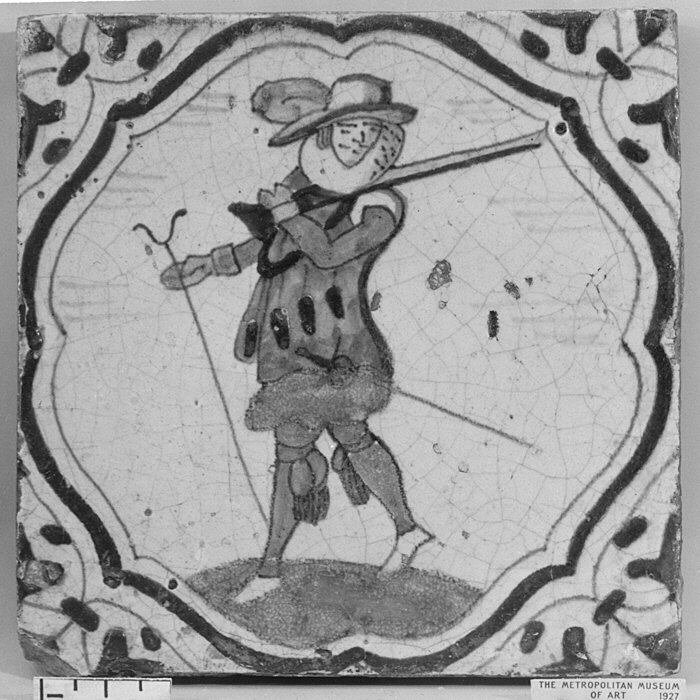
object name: tile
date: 1620-1640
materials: earthenware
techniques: glazing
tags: men